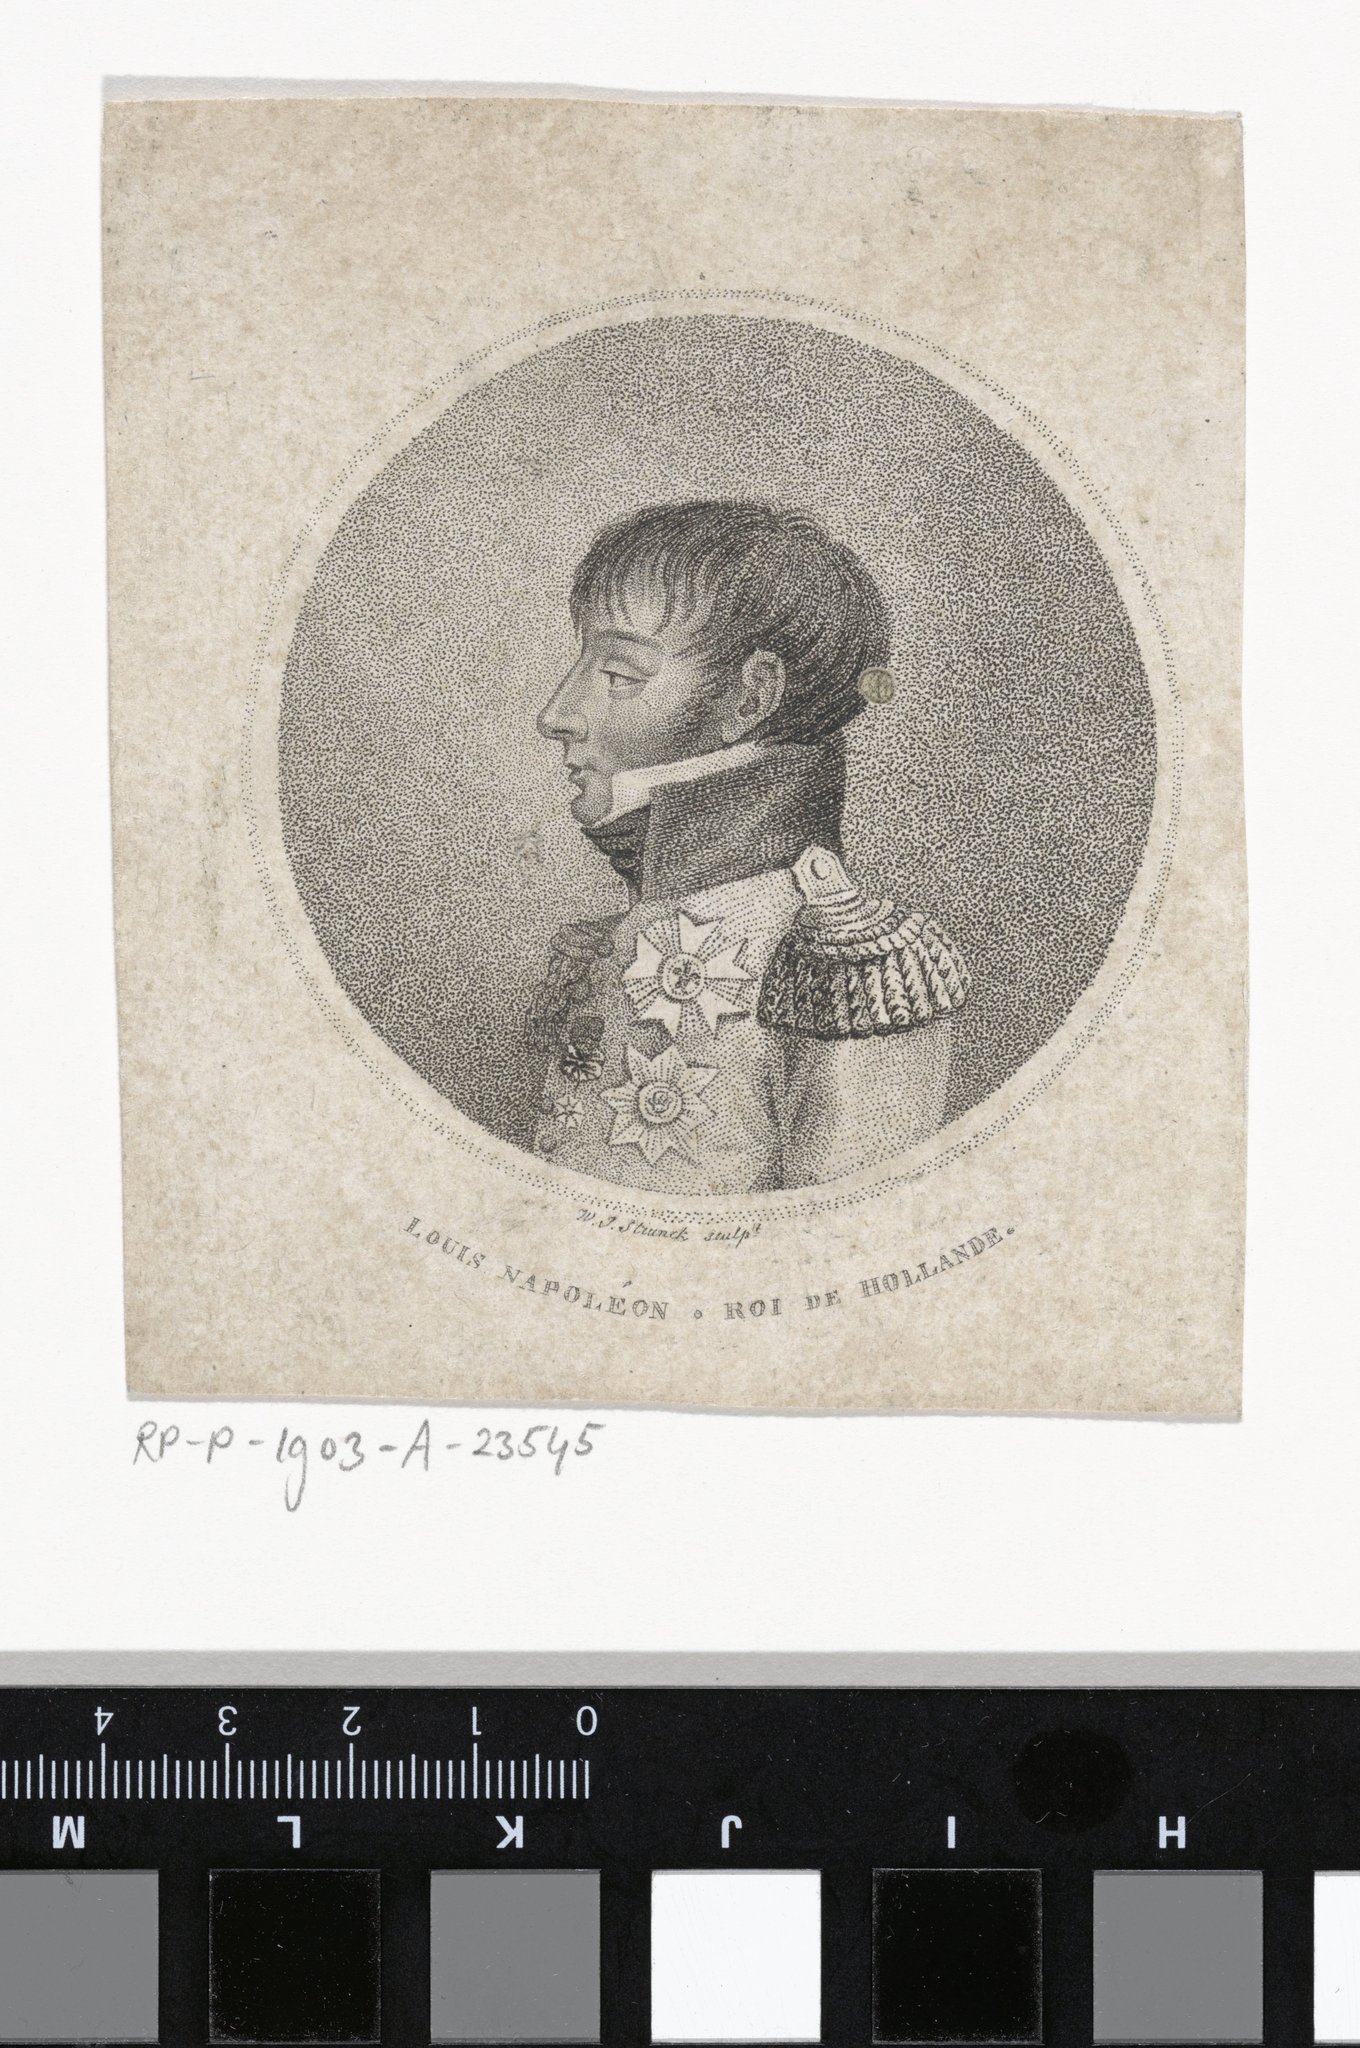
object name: print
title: Portret van Lodewijk Napoleon Bonaparte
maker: jacob willem strunck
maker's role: print maker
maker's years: 1766-1813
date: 1806-1810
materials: paper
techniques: etching, engraving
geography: netherlands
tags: louis napoleon (king of holland)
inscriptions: collector's mark: Lugt 2228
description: Portret van Lodewijk Napoleon Bonaparte als koning van Nederland.